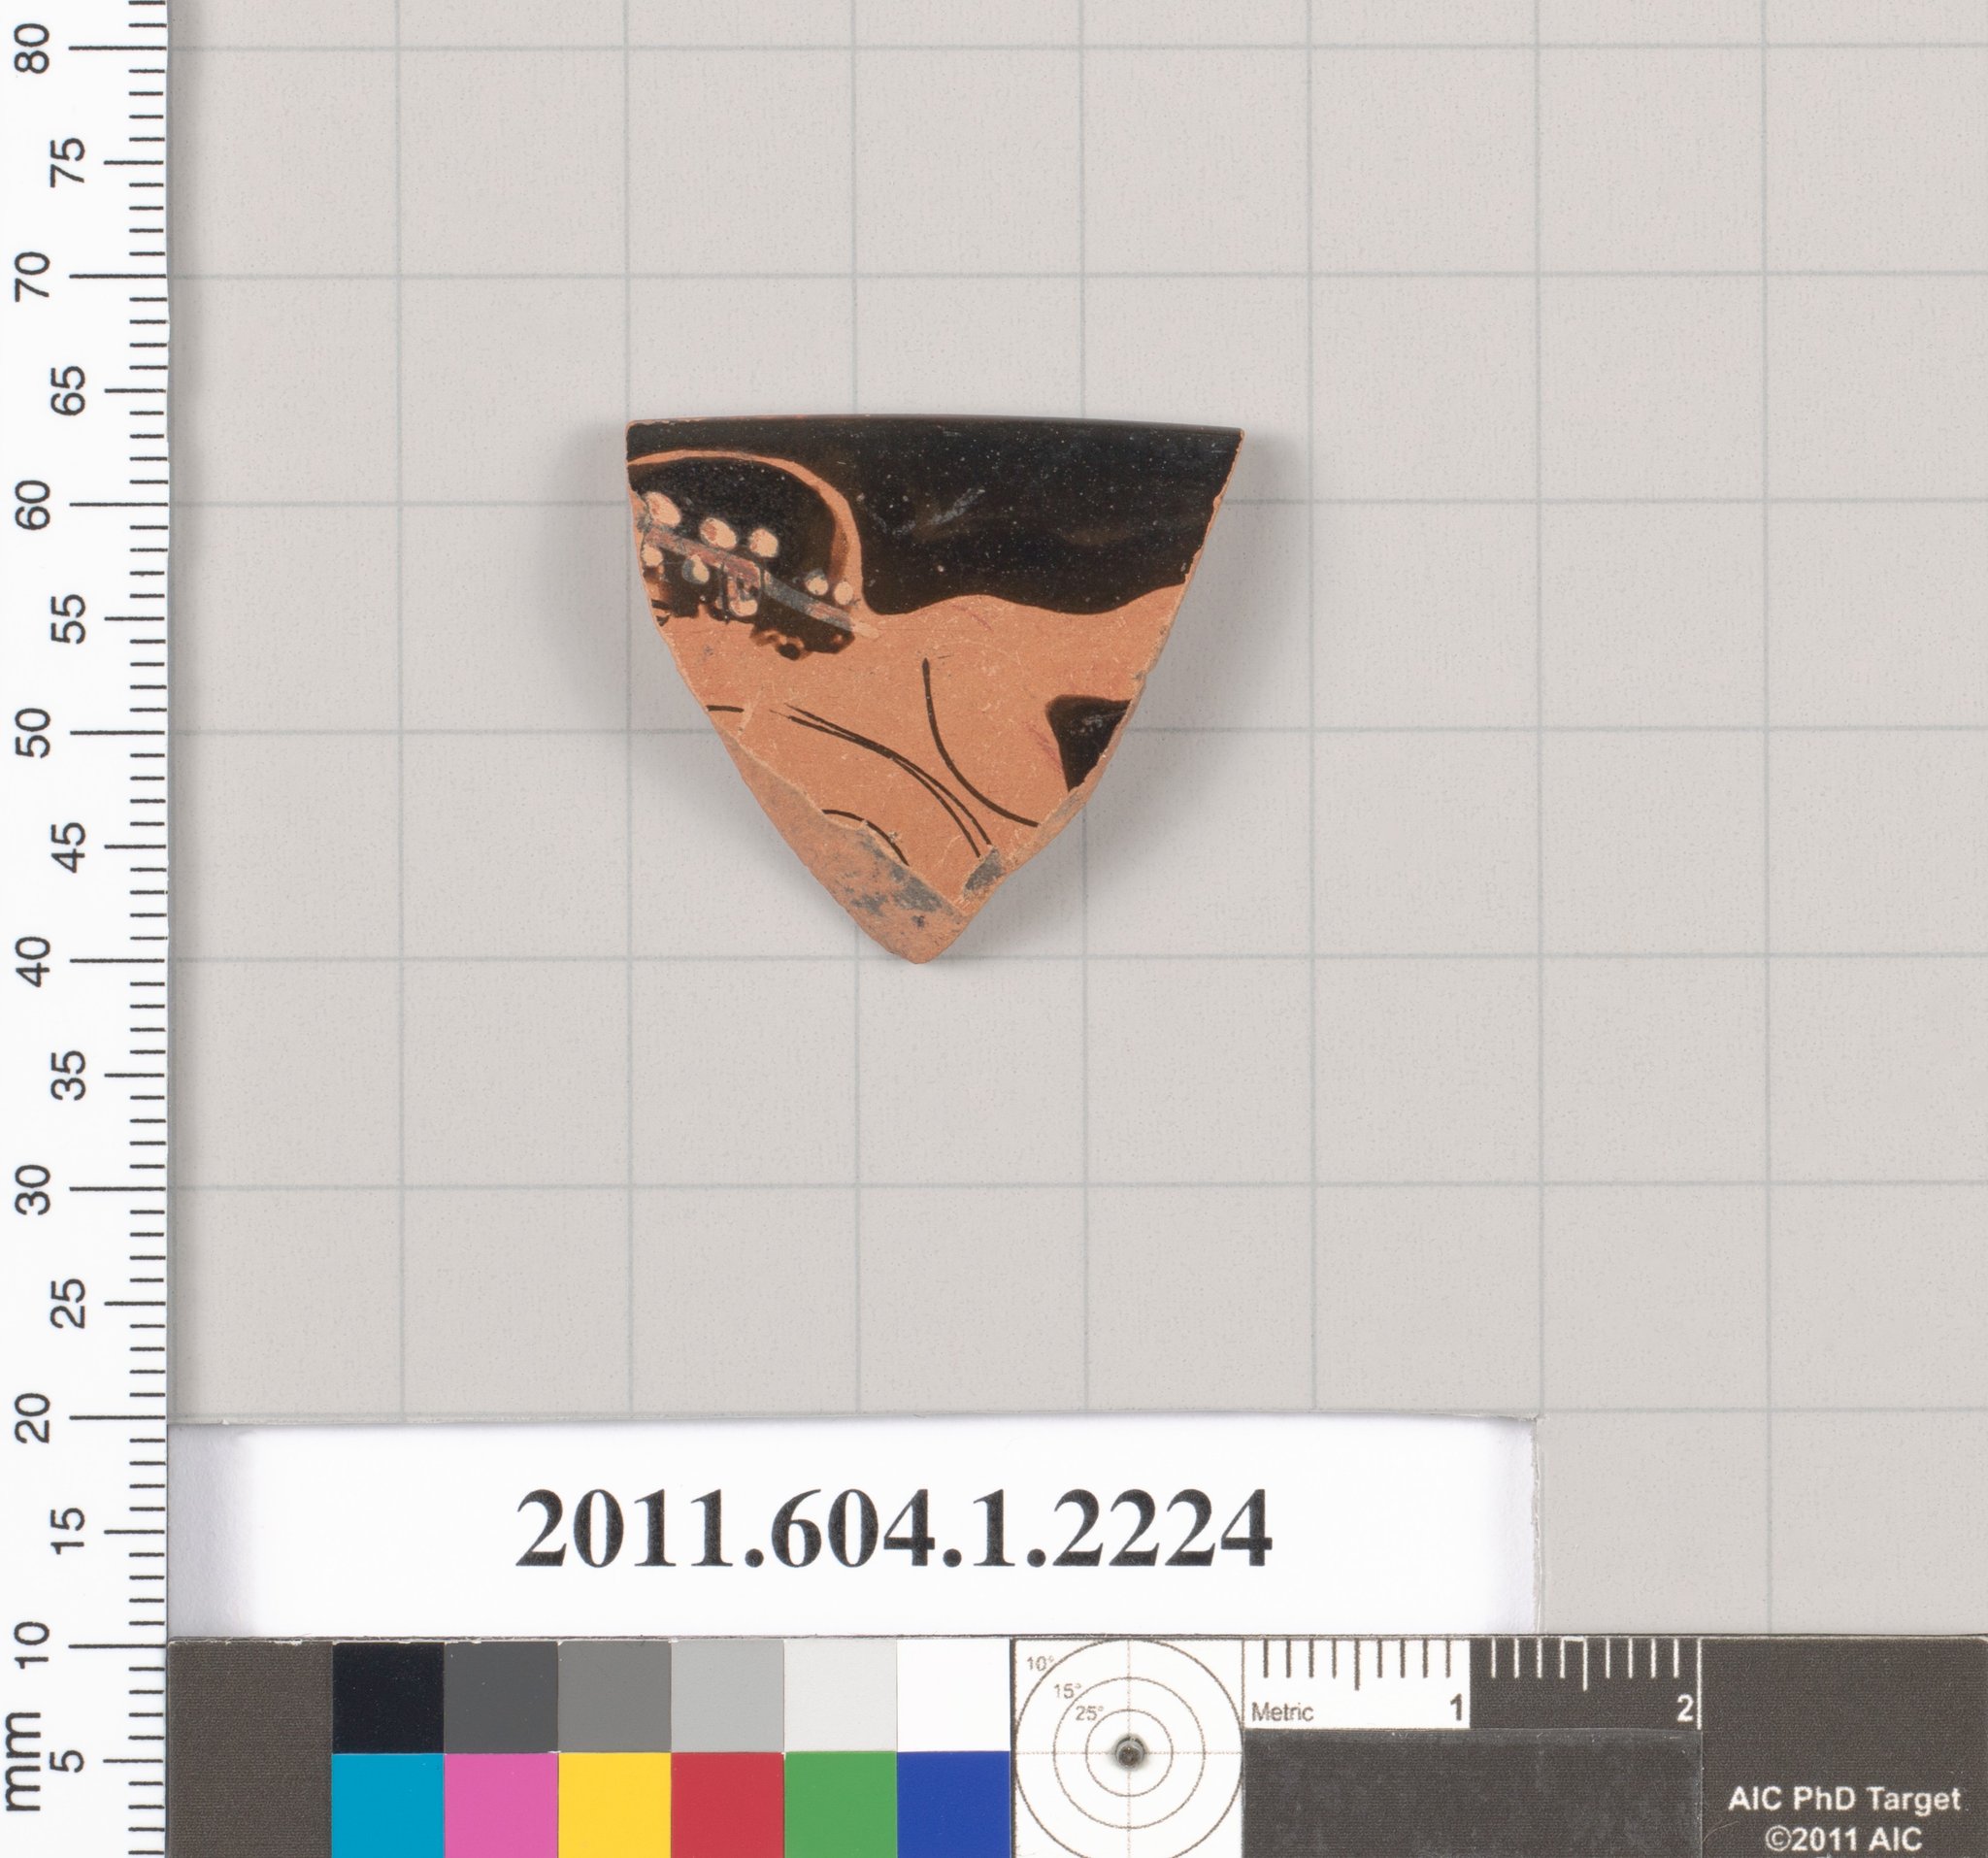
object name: kylix fragment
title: Terracotta rim fragment of a kylix (drinking cup)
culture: greek, attic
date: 467-435 BCE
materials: terracotta